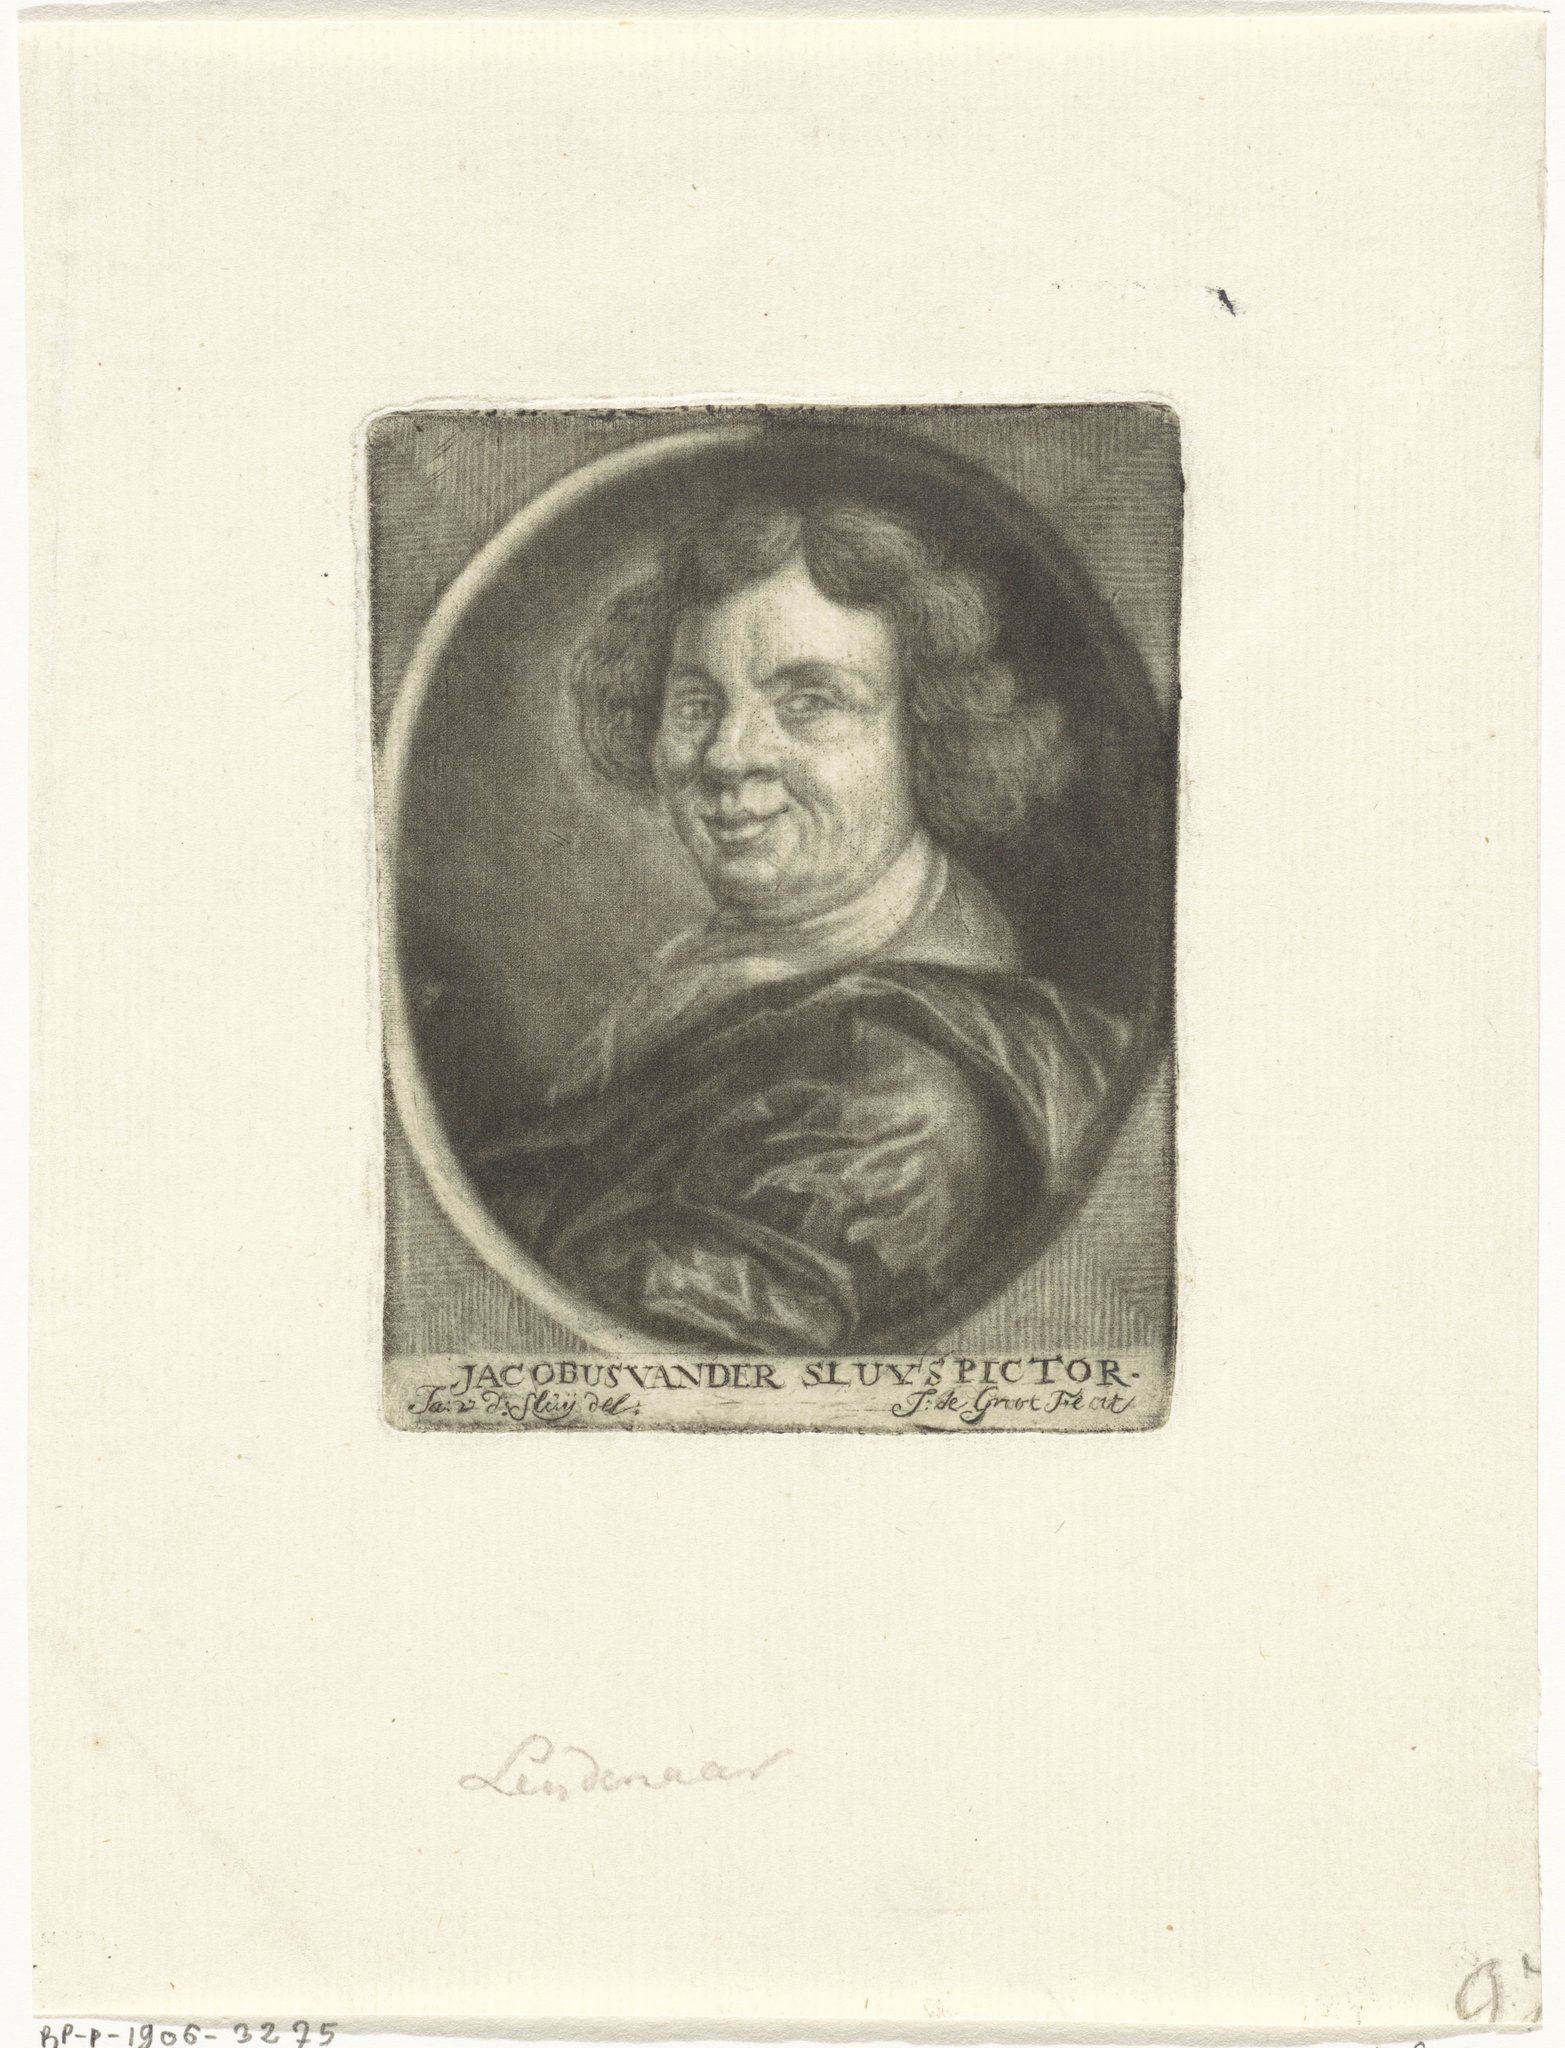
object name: print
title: Zelfportret van de schilder Jacob van der Sluys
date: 1698-1776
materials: paper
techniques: engraving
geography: northern netherlands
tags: leiden, painter, jacob van der sluys, portrait, self-portrait of artist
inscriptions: collector's mark: Lugt 2228